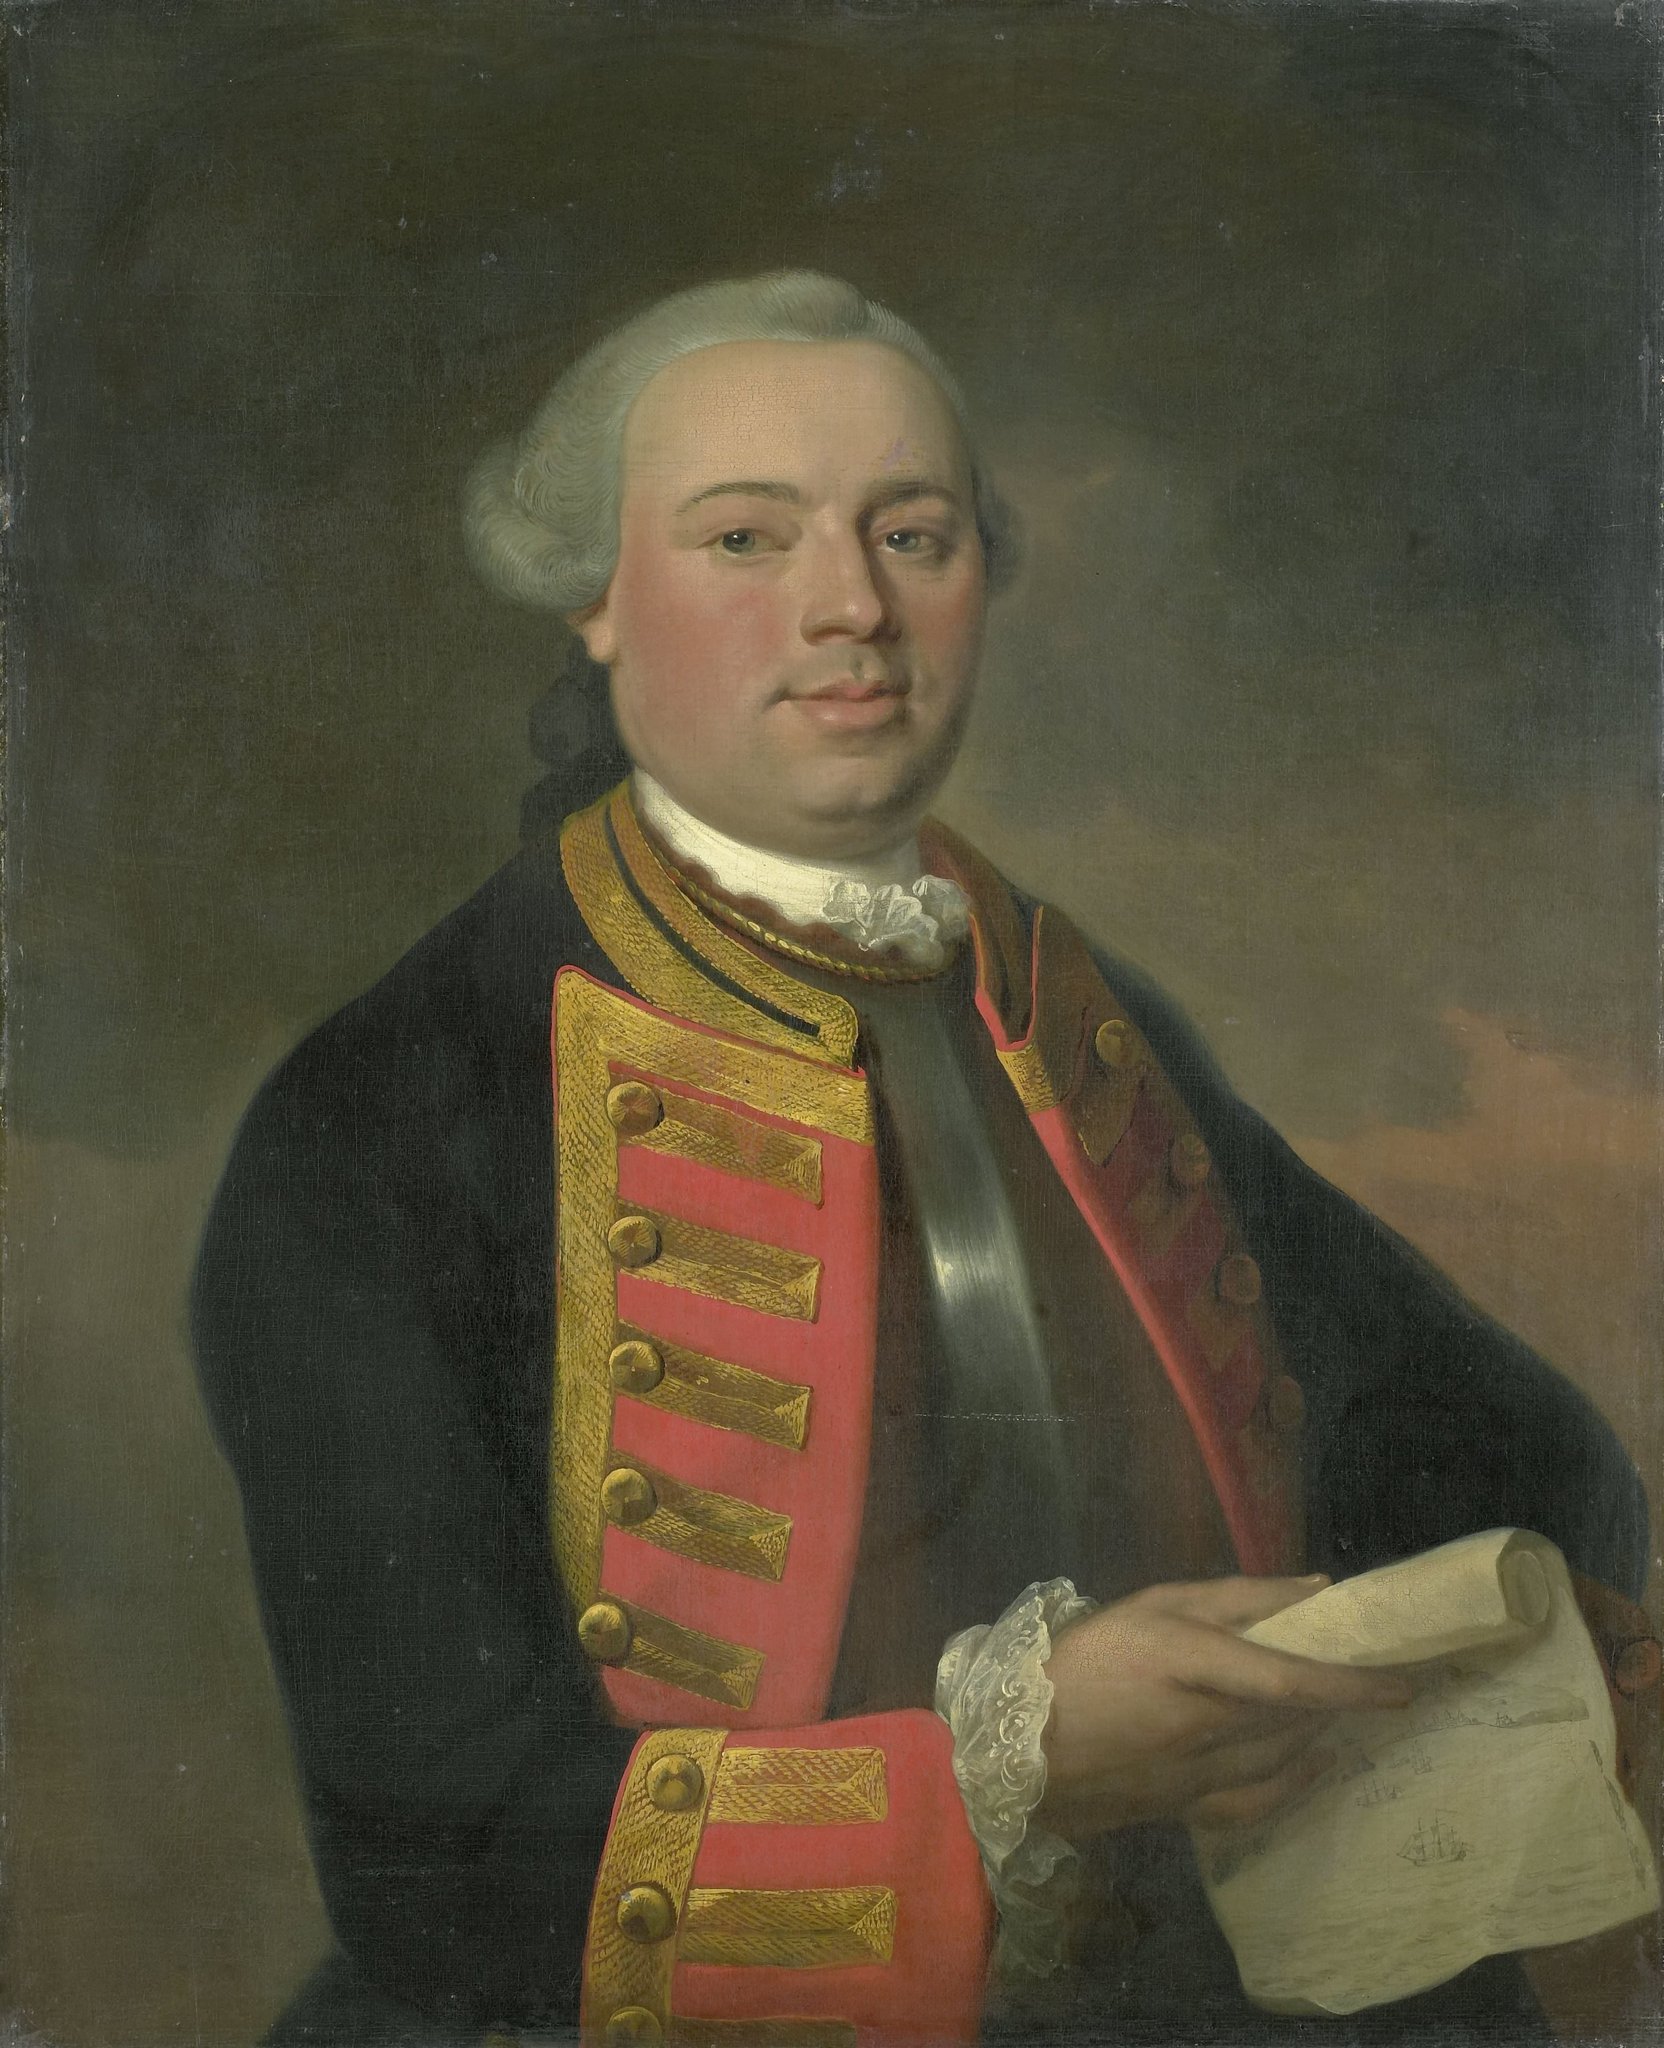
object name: painting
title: Johan Arnold Zoutman (1724-93), Vice Admiral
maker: august christian hauck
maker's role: draughtsman, painter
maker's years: 1742-1801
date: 1770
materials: canvas, oil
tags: johan arnold zoutman, historical persons, commander-in-chief, admiral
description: Portret van Johan Arnold Zoutman, vice-admiraal. Ten halven lijve met in de rechterhand een rol papier met een tekening van schepen voor een kust. Pendant van SK-A-633.